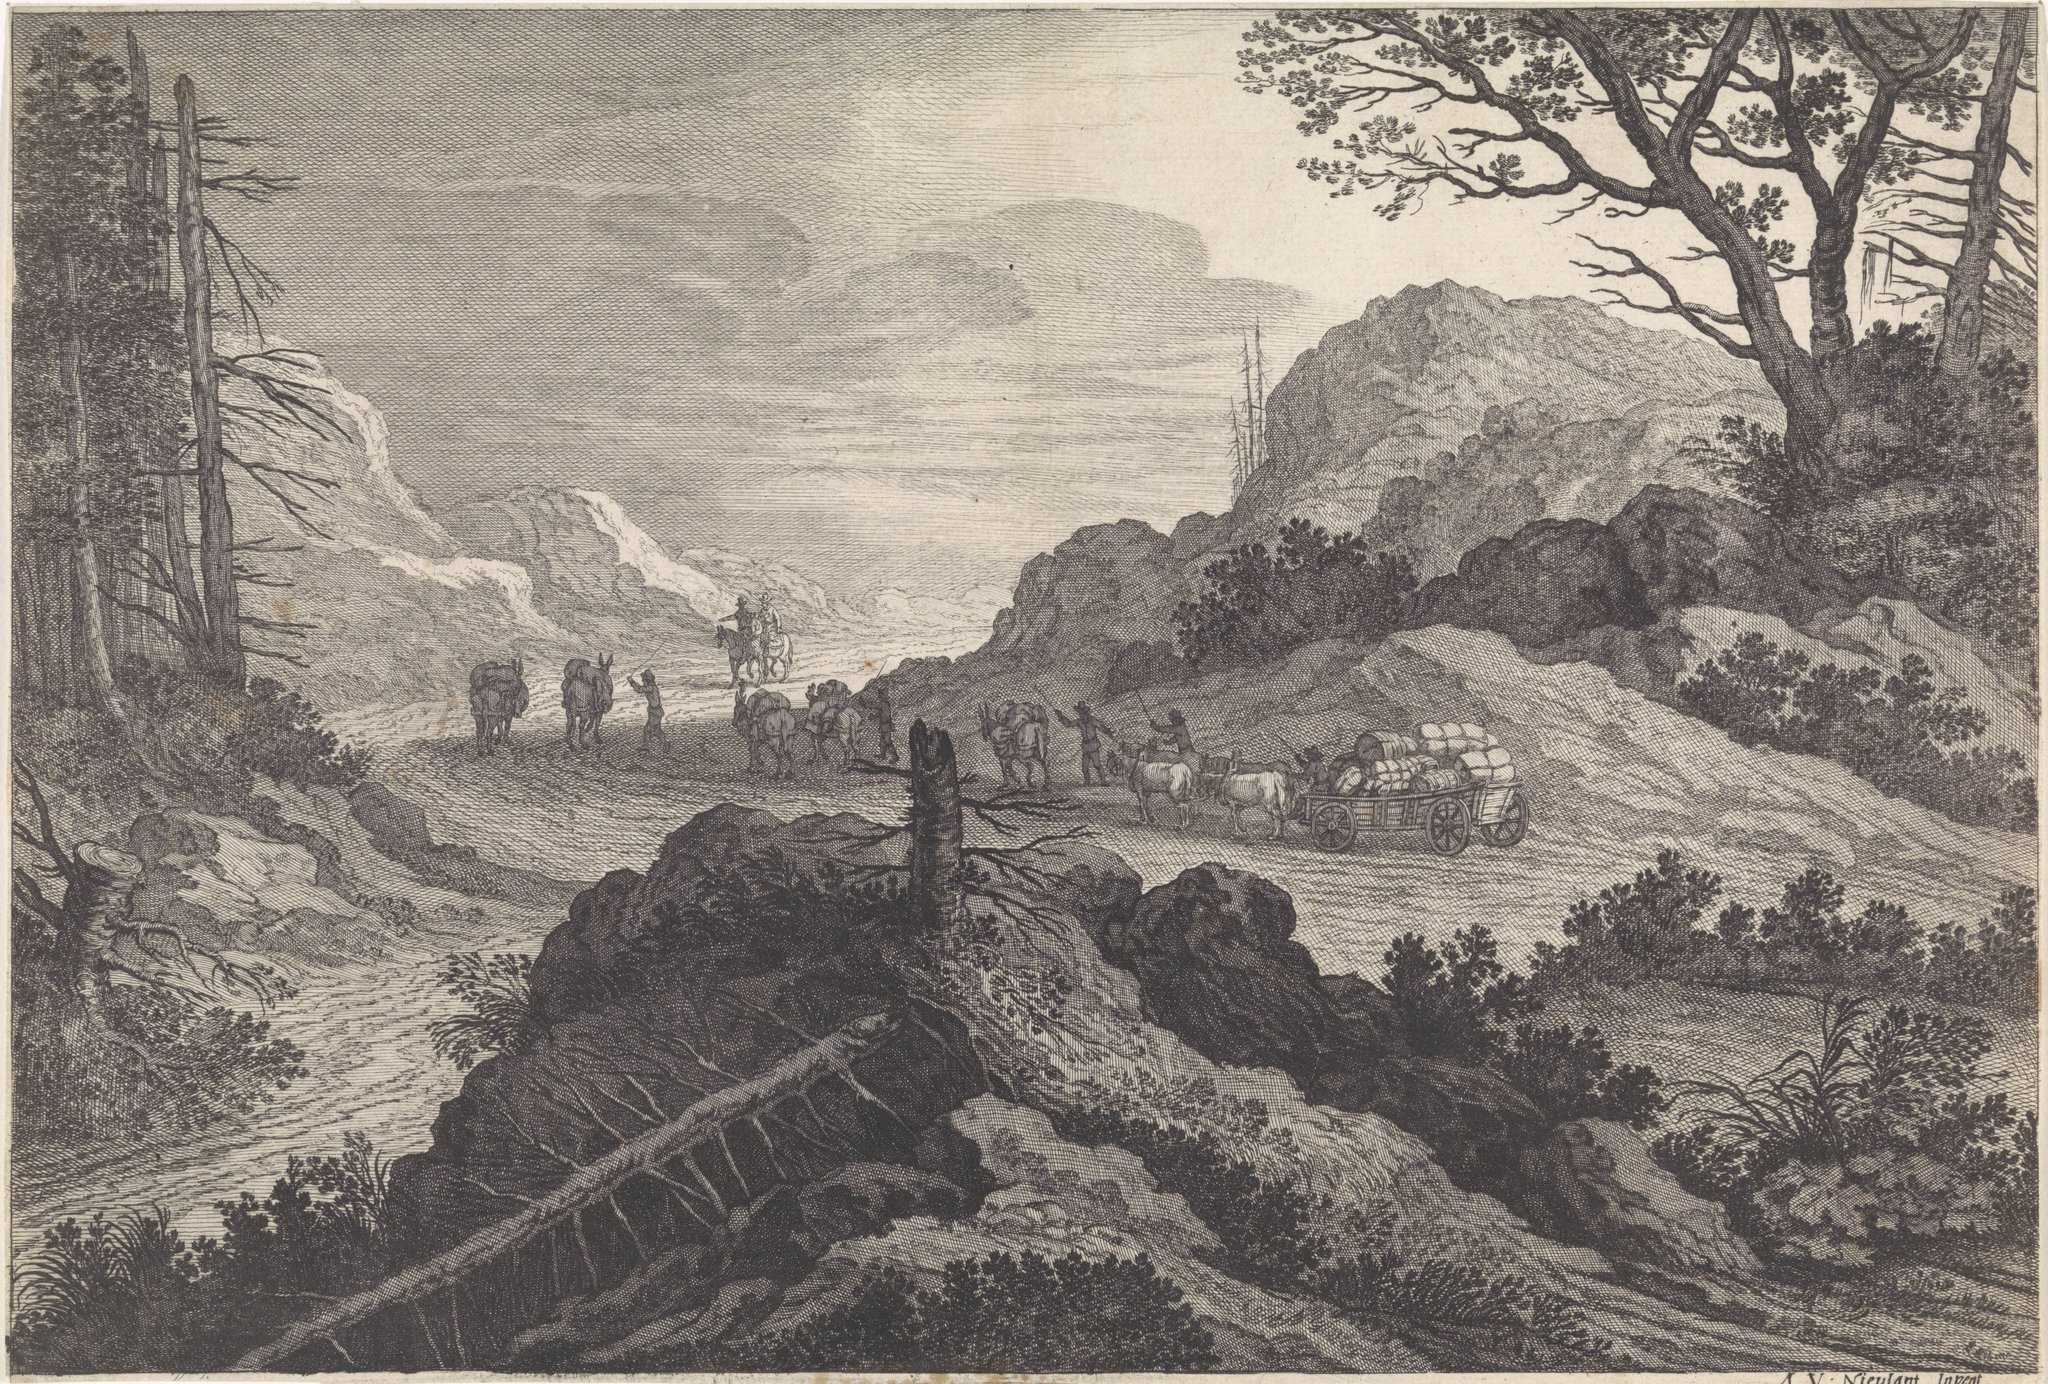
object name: print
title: Pakezels op een weg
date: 1623-1653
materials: paper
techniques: engraving, etching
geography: amsterdam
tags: ass, donkey, four-wheeled, animal-drawn vehicle, e.g.: cab, carriage, coach, road, path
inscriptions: collector's mark: Lugt 240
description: Op en weg lopen een aantal pakezels en hun drijvers. Achteraan rijdt een volgeladen kar, getroken door paarden. Op de voorgrond een omgevallen boom. Prent uit een serie landschappen.